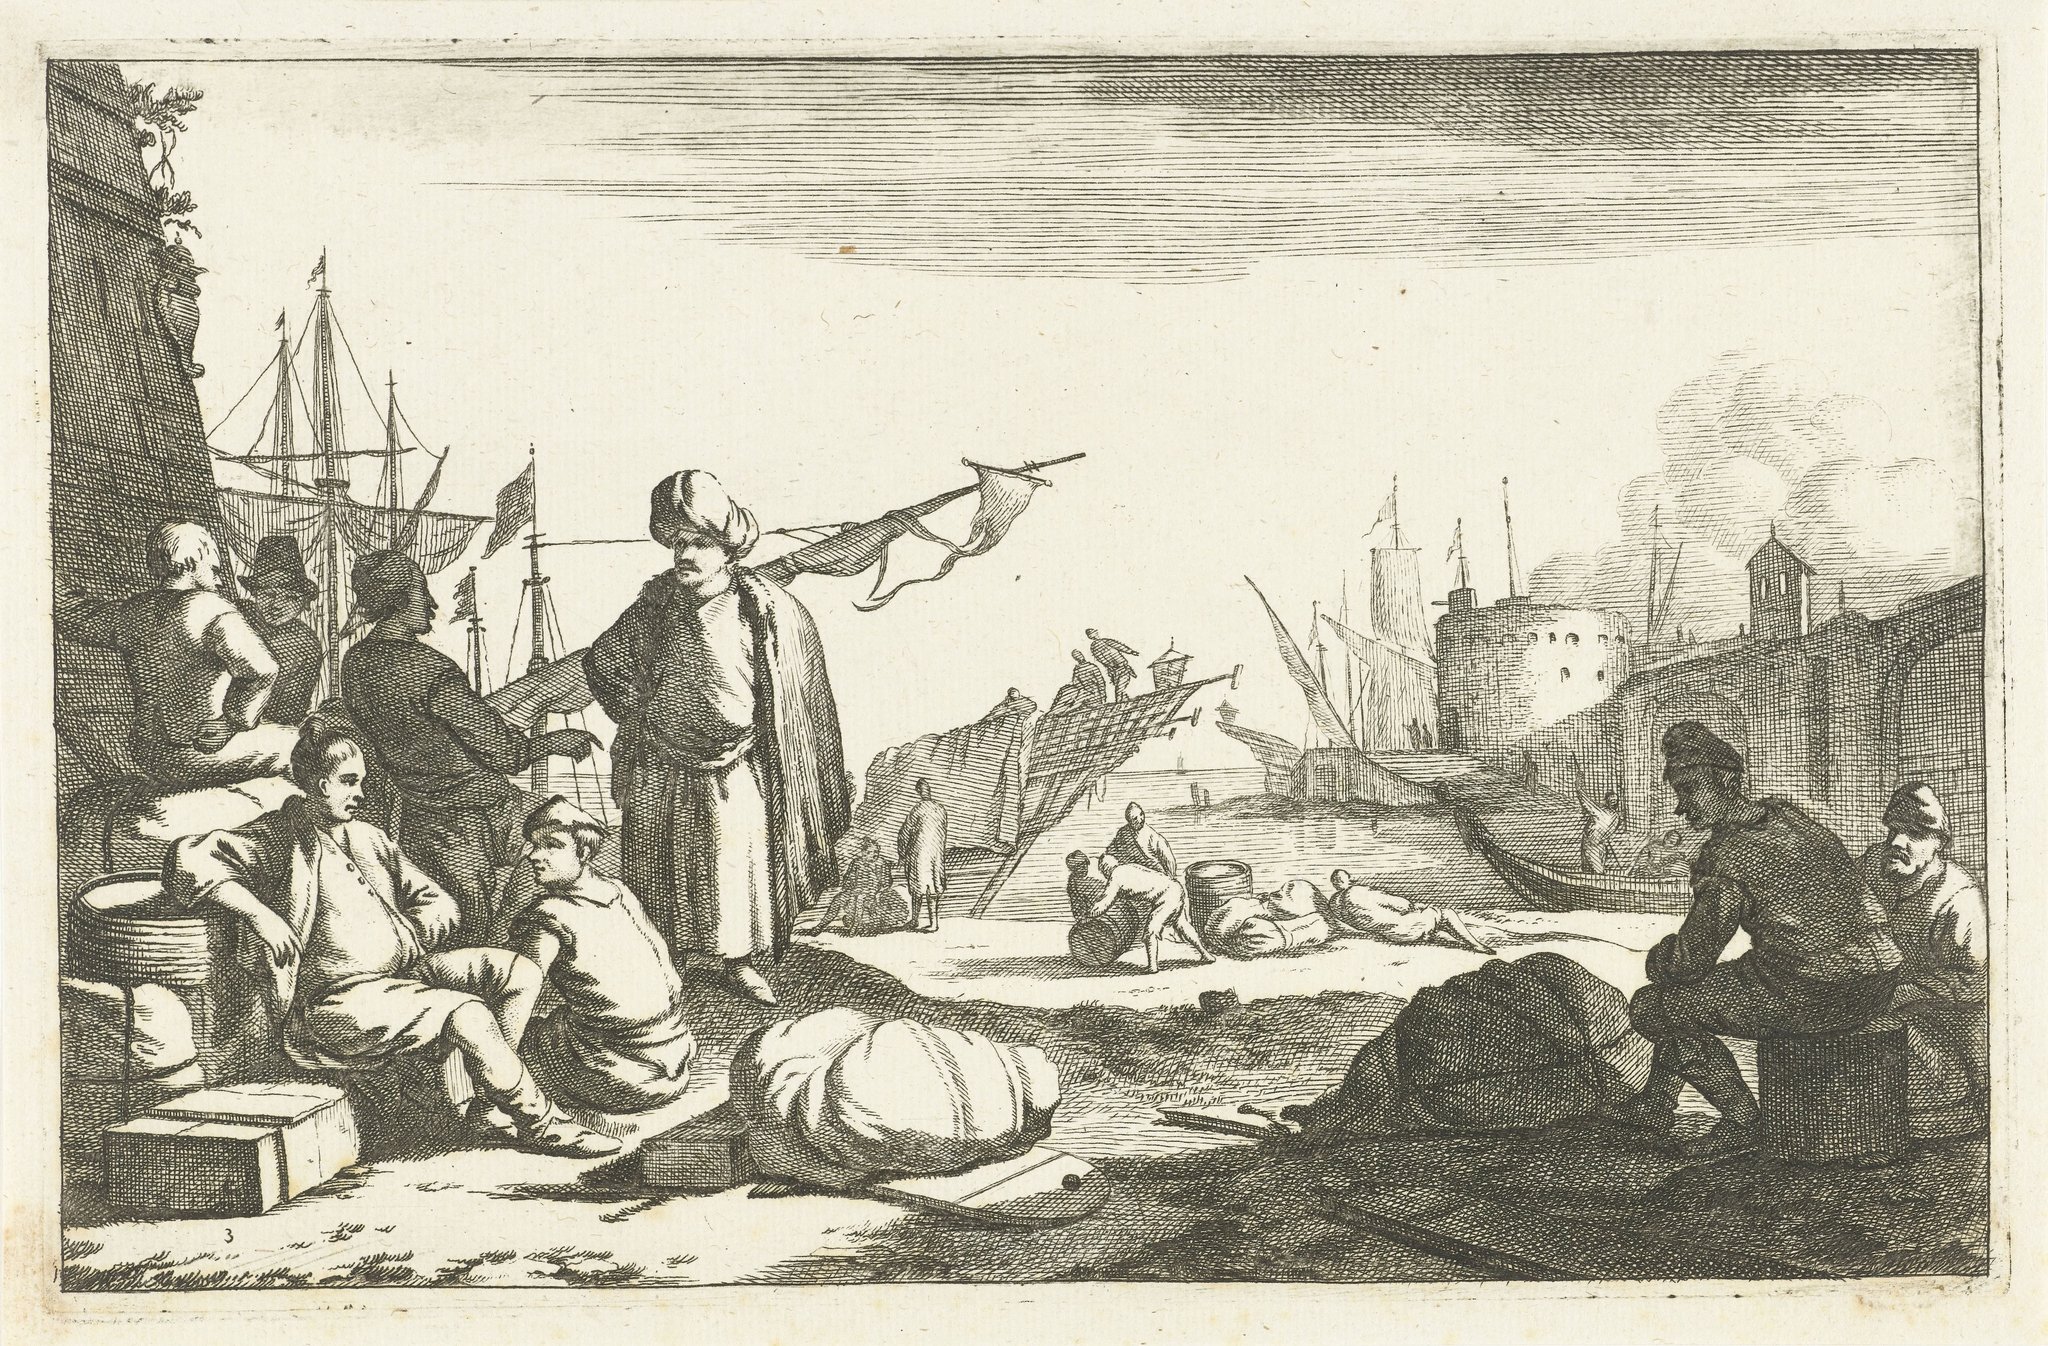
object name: print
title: Aliqui Portus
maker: johannes gronsveld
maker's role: draughtsman, painter, print maker, publisher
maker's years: 1658-1728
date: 1679-1728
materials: paper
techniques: engraving, etching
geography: amsterdam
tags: harbour (+ four persons or more ~ traffic and transport)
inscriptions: collector's mark: Lugt 240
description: Haven met links op de voorgrond een groep buitenlandse kooplieden, staand en zittend bij een lading, daarachter een zeilschip. Rechts twee zittende kooplieden en rechts op de achtergrond een brug, toren en zeilschepen. Derde prent uit een serie van twaalf met Italiaanse havens.